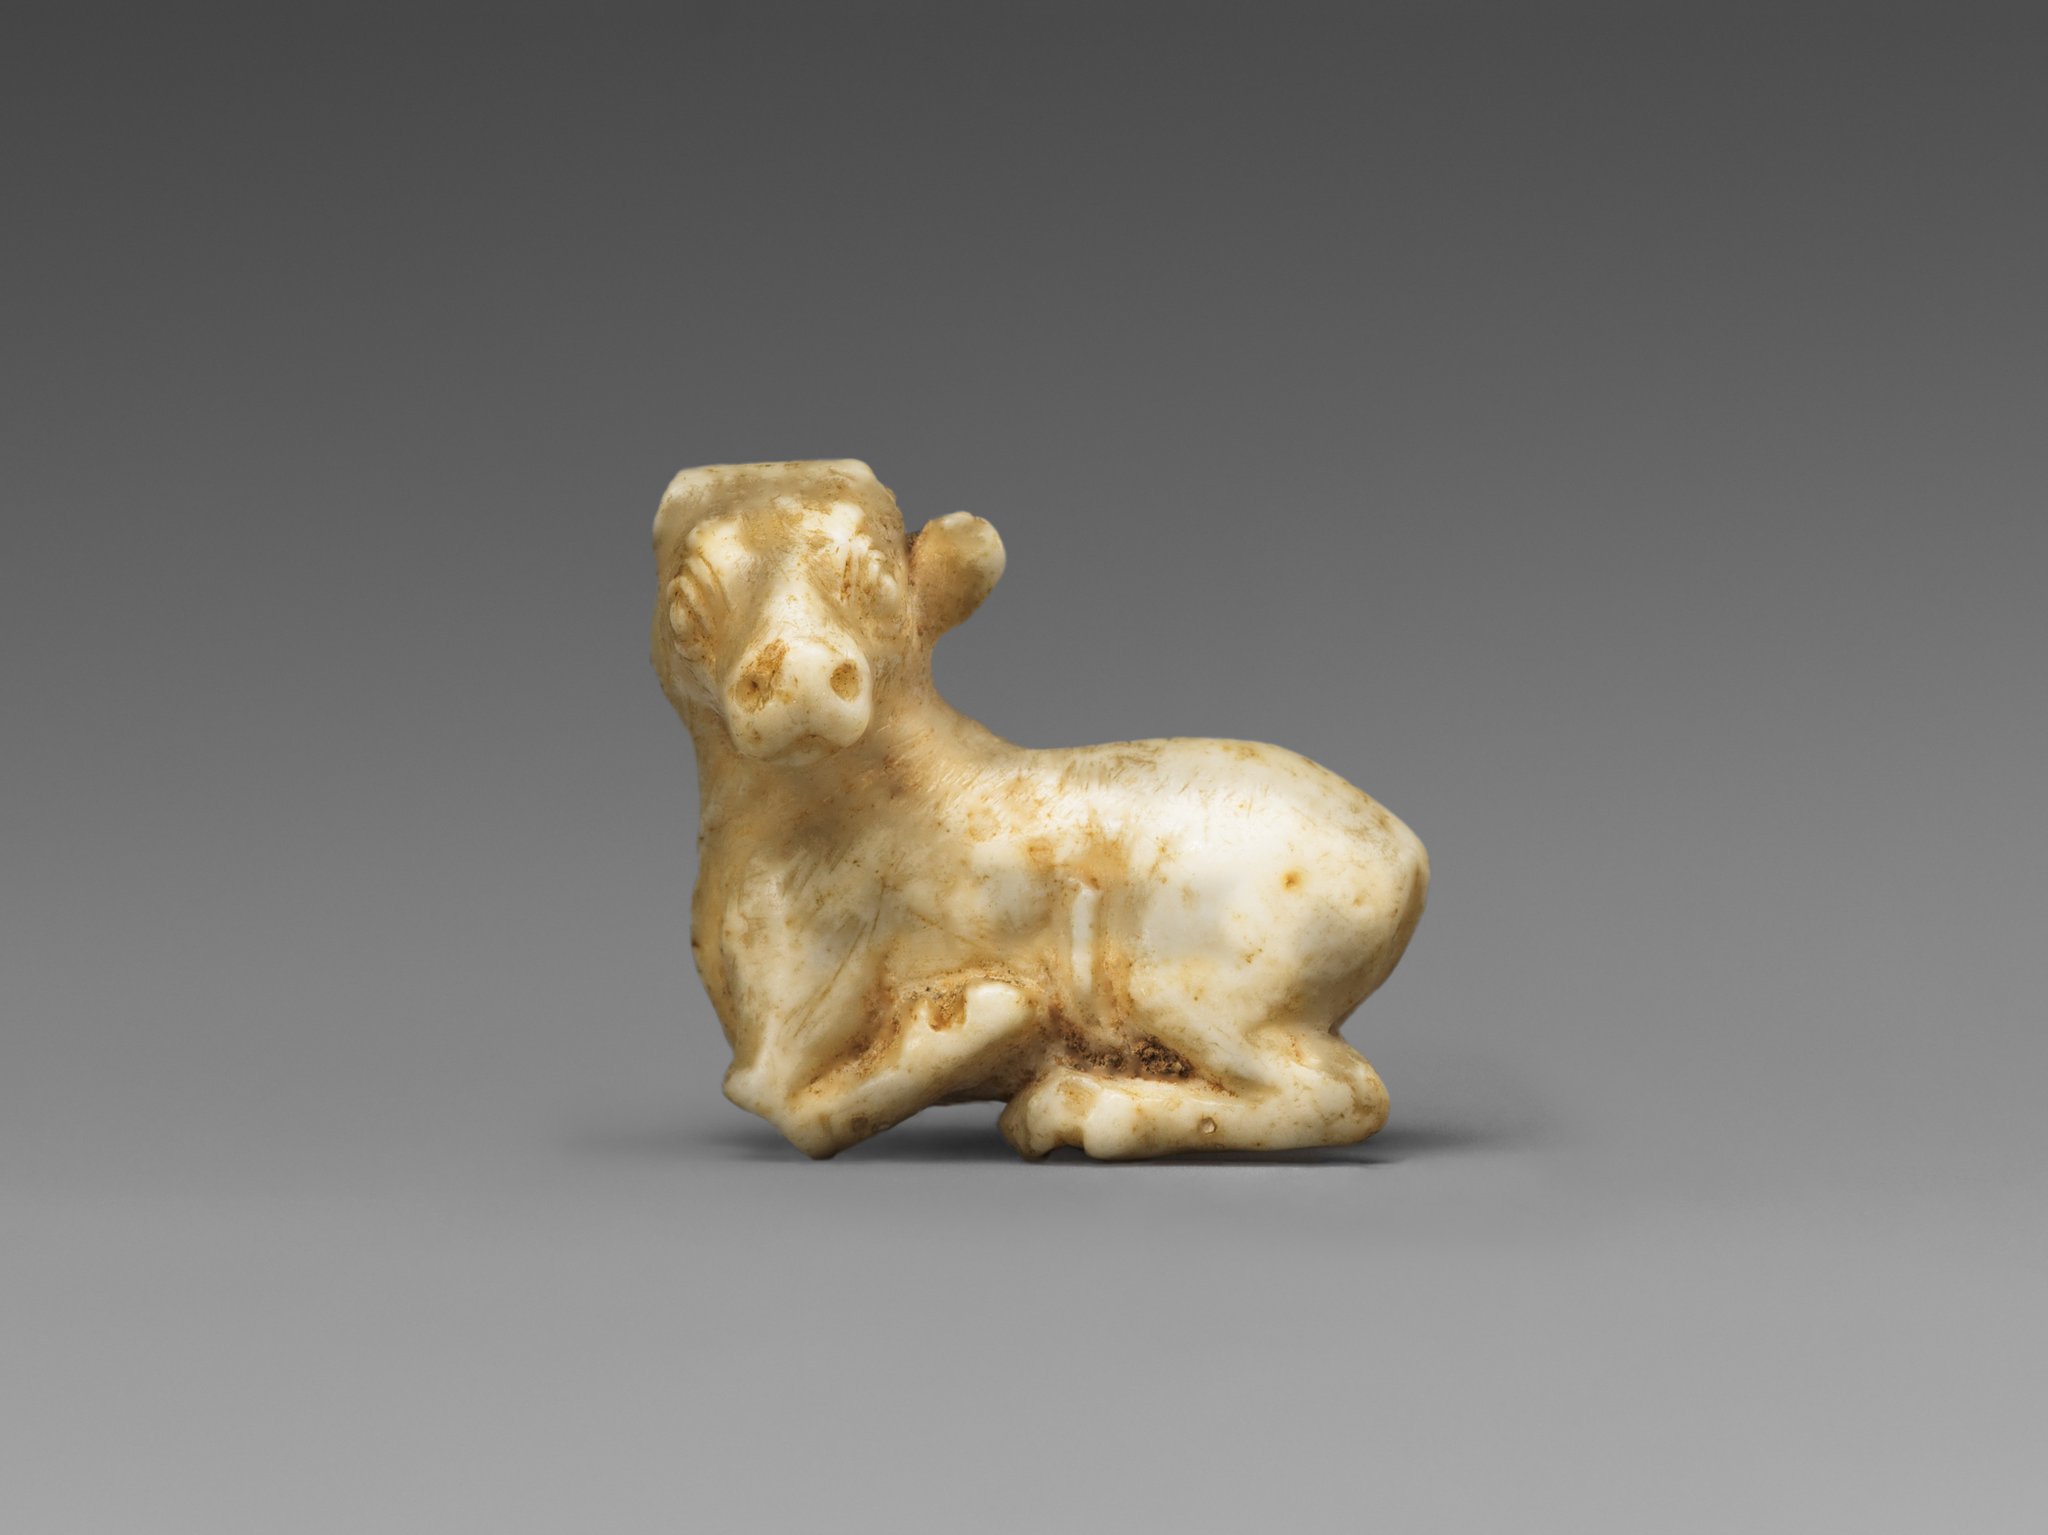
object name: sculpture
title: Bull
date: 3100 BCE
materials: shell, stone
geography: mesopotamia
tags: bulls